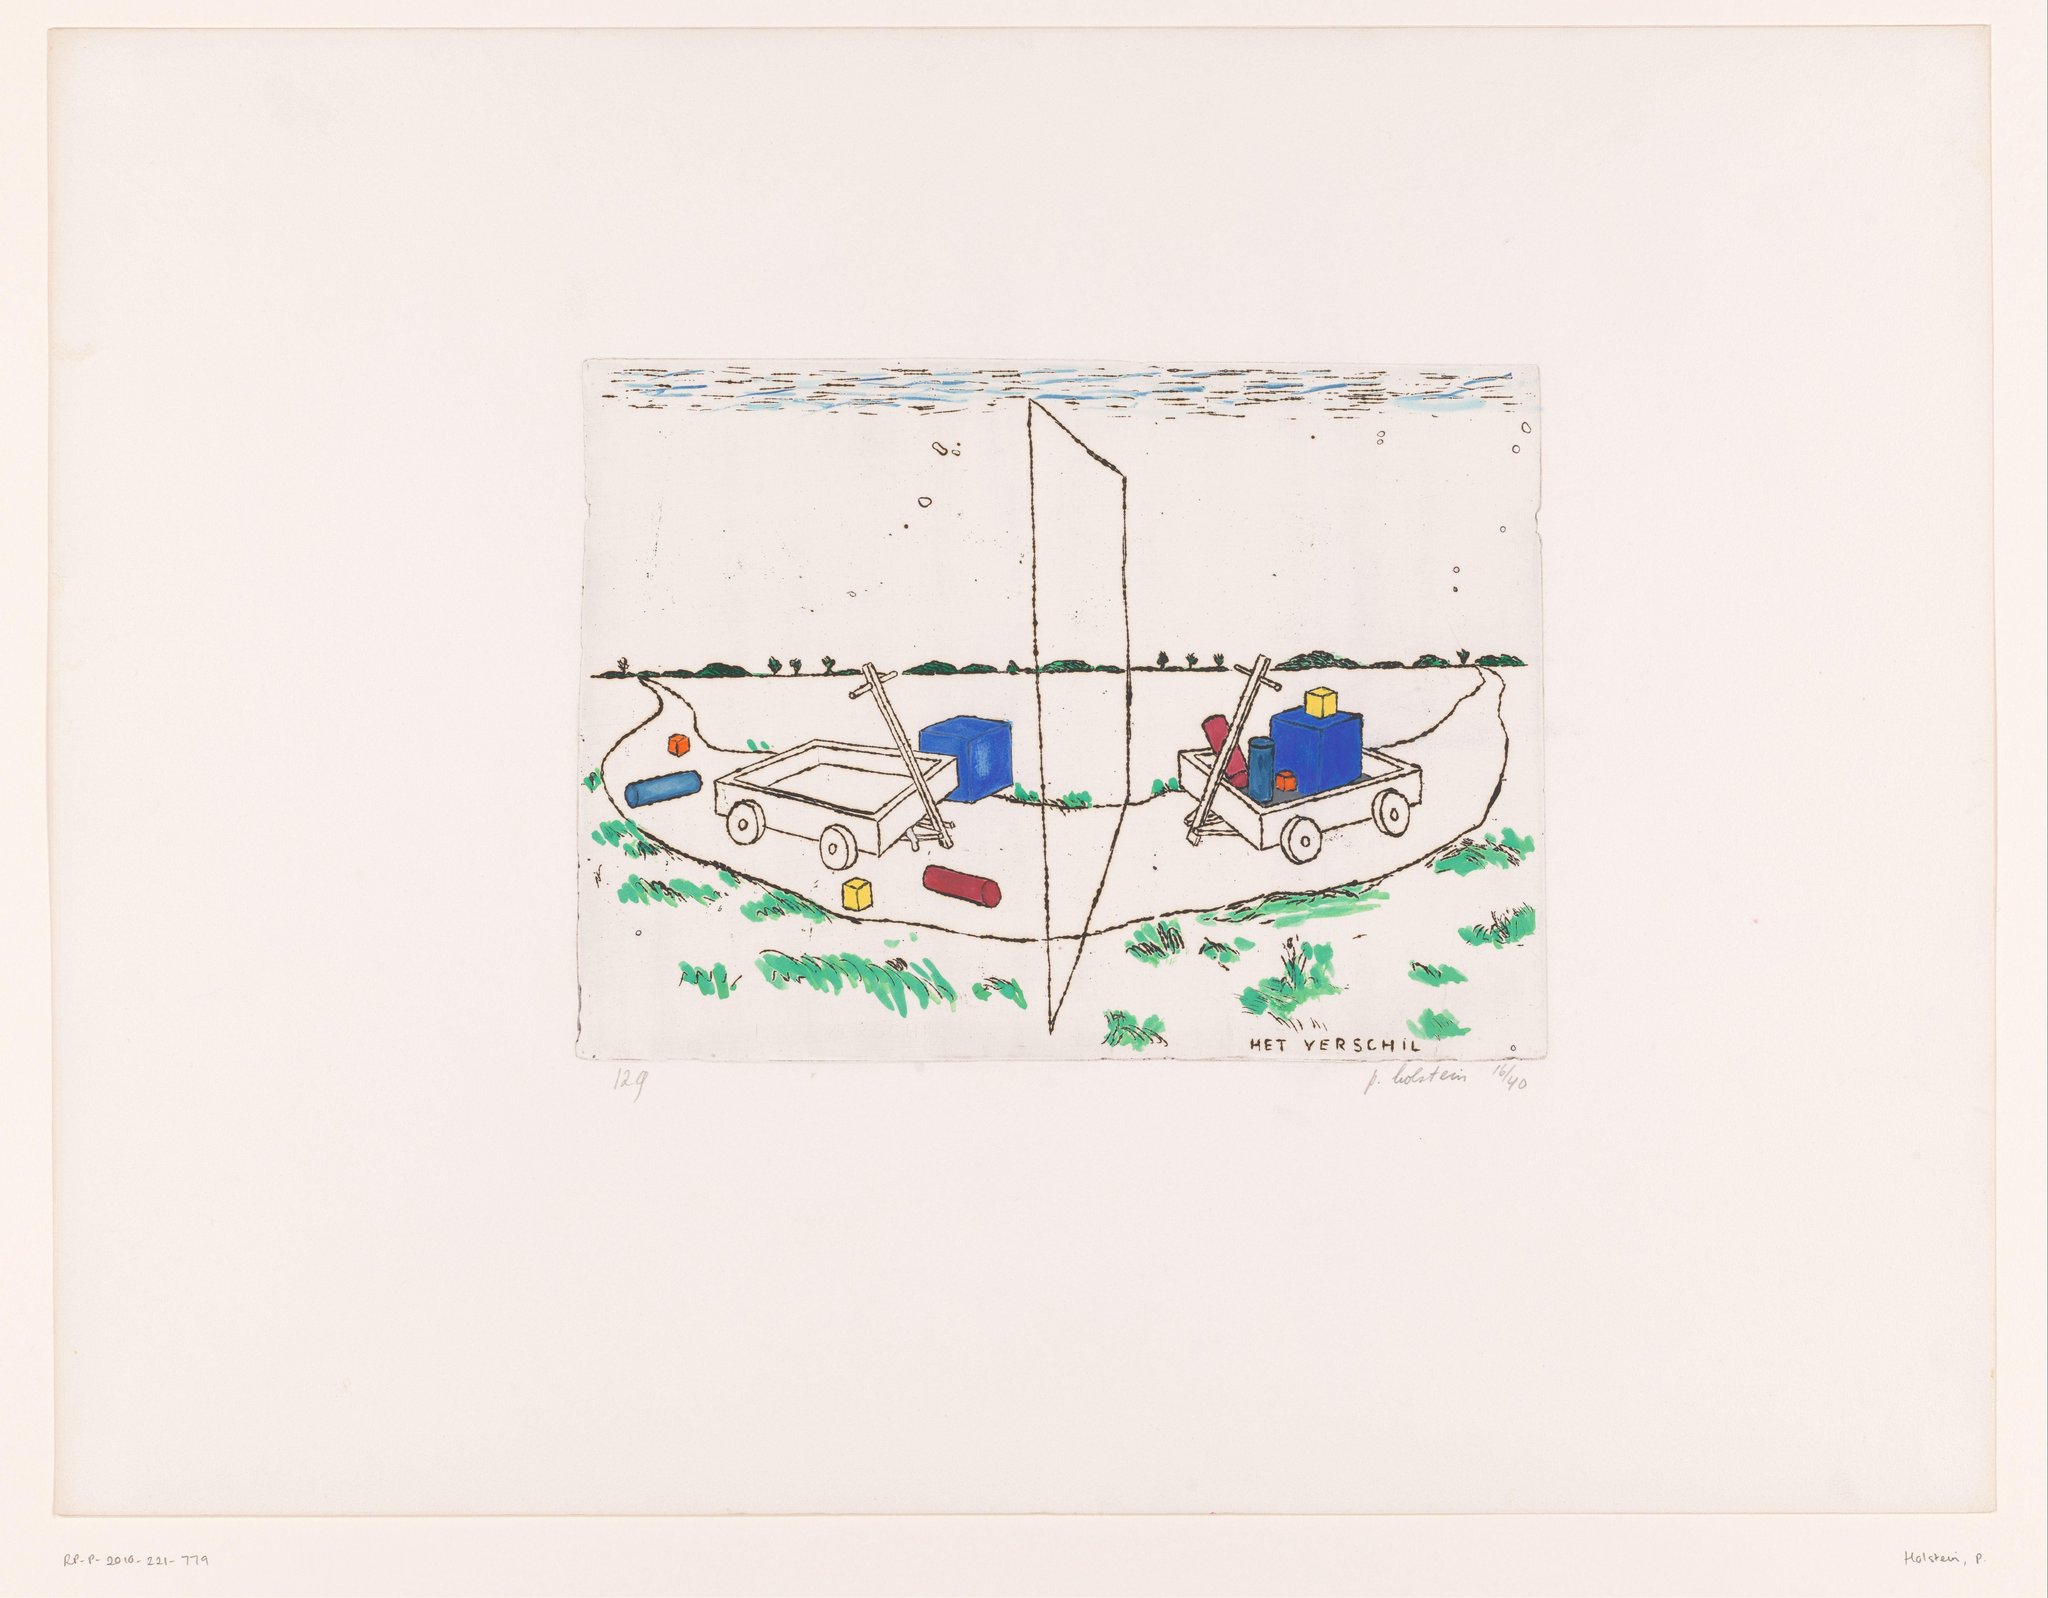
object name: print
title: Het verschil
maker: pieter holstein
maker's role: draughtsman, painter, print maker, sculptor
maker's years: 1934-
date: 1971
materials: paper, watercolor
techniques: brush, etching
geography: amsterdam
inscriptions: inscription: ‘129’, title: ‘HET VERSCHIL’, signature: ‘p. holstein’, edition: ‘16/40’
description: Twee trekkarren tegenover elkaar, alsof zij elkaar reflecteren middels het transparante vlak ertussen.